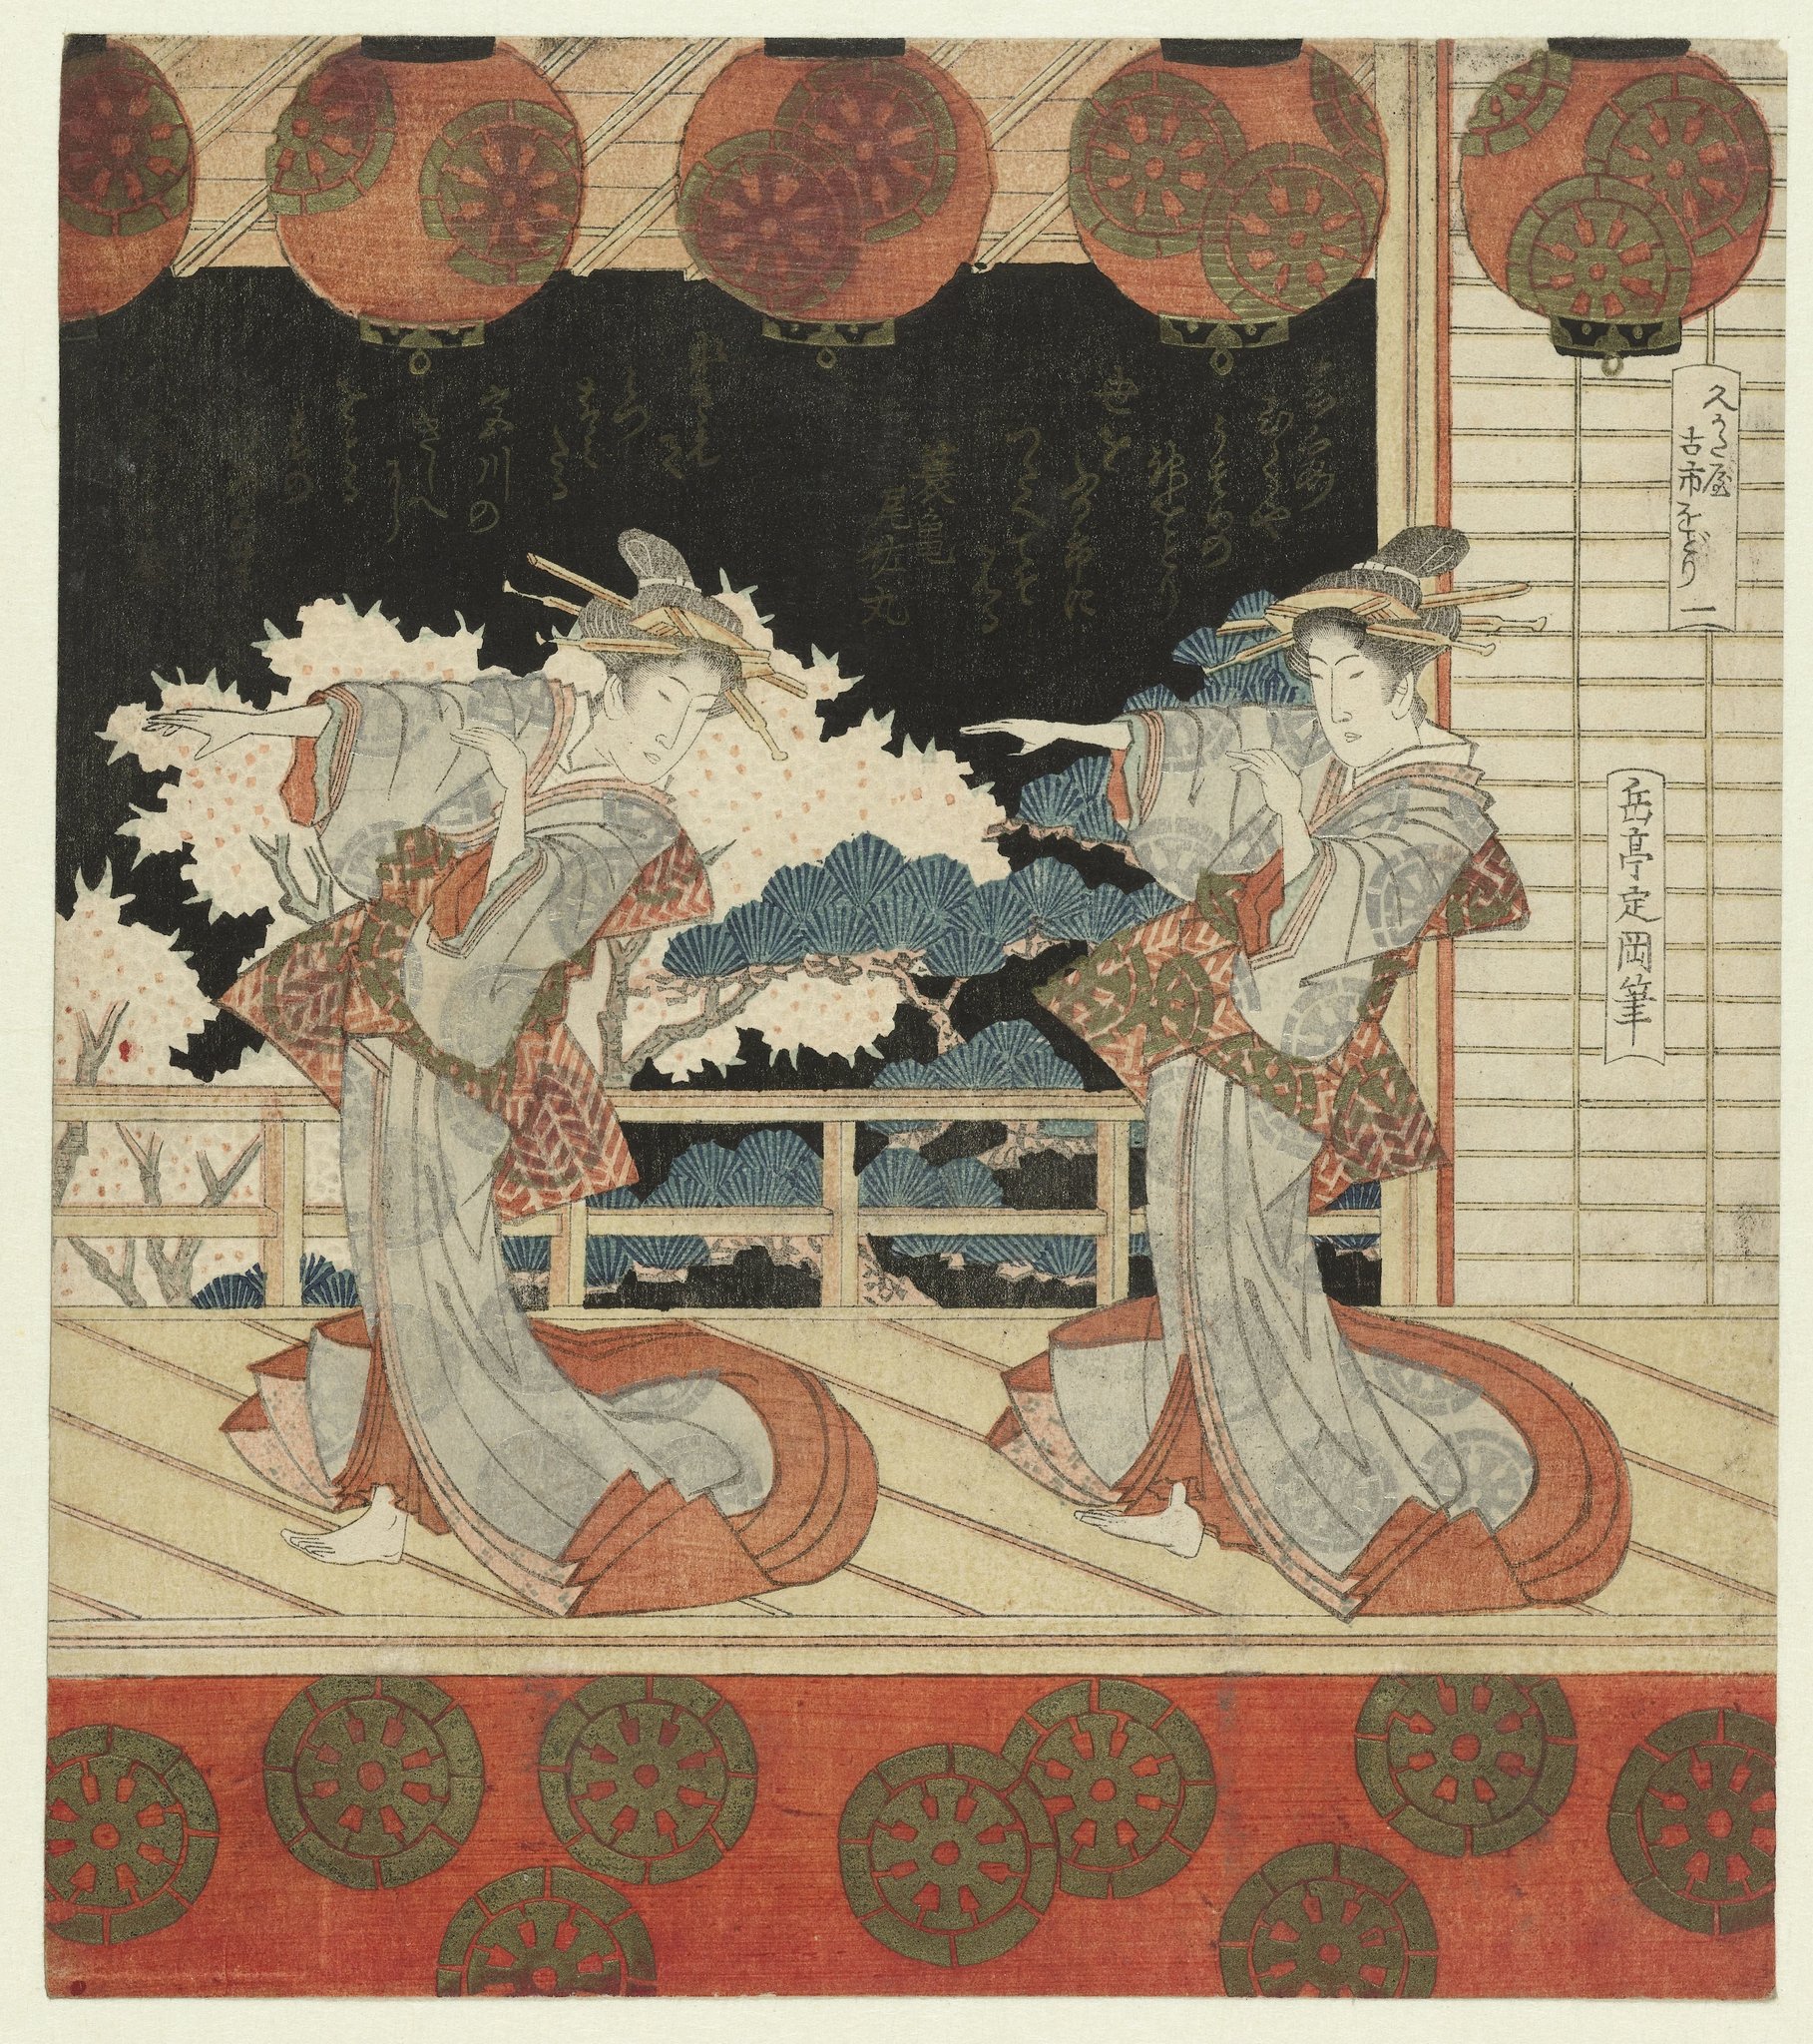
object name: surimono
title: One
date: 1824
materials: paper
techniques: blind stamped, woodcut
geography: japan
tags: courtesan, hetaera, ballet group; dancers on the stage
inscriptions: collector's mark, verso, stamped: Lugt 2228, collector's mark, passe-partout, bottom left, printed: JABdH with a rooster.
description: Een surimono is een luxe uitgevoerde prent waarop beeld met één of meerdere gedichten gecombineerd is. Bij het drukken van een surimono werd vaak gebruik gemaakt van dikker papier, blinddruk en metaal pigmenten, zoals koper- en zilverpoeder. De prenten werden vaak in opdracht van dichters gemaakt en als exclusief geschenk aan vrienden en relaties gegeven.